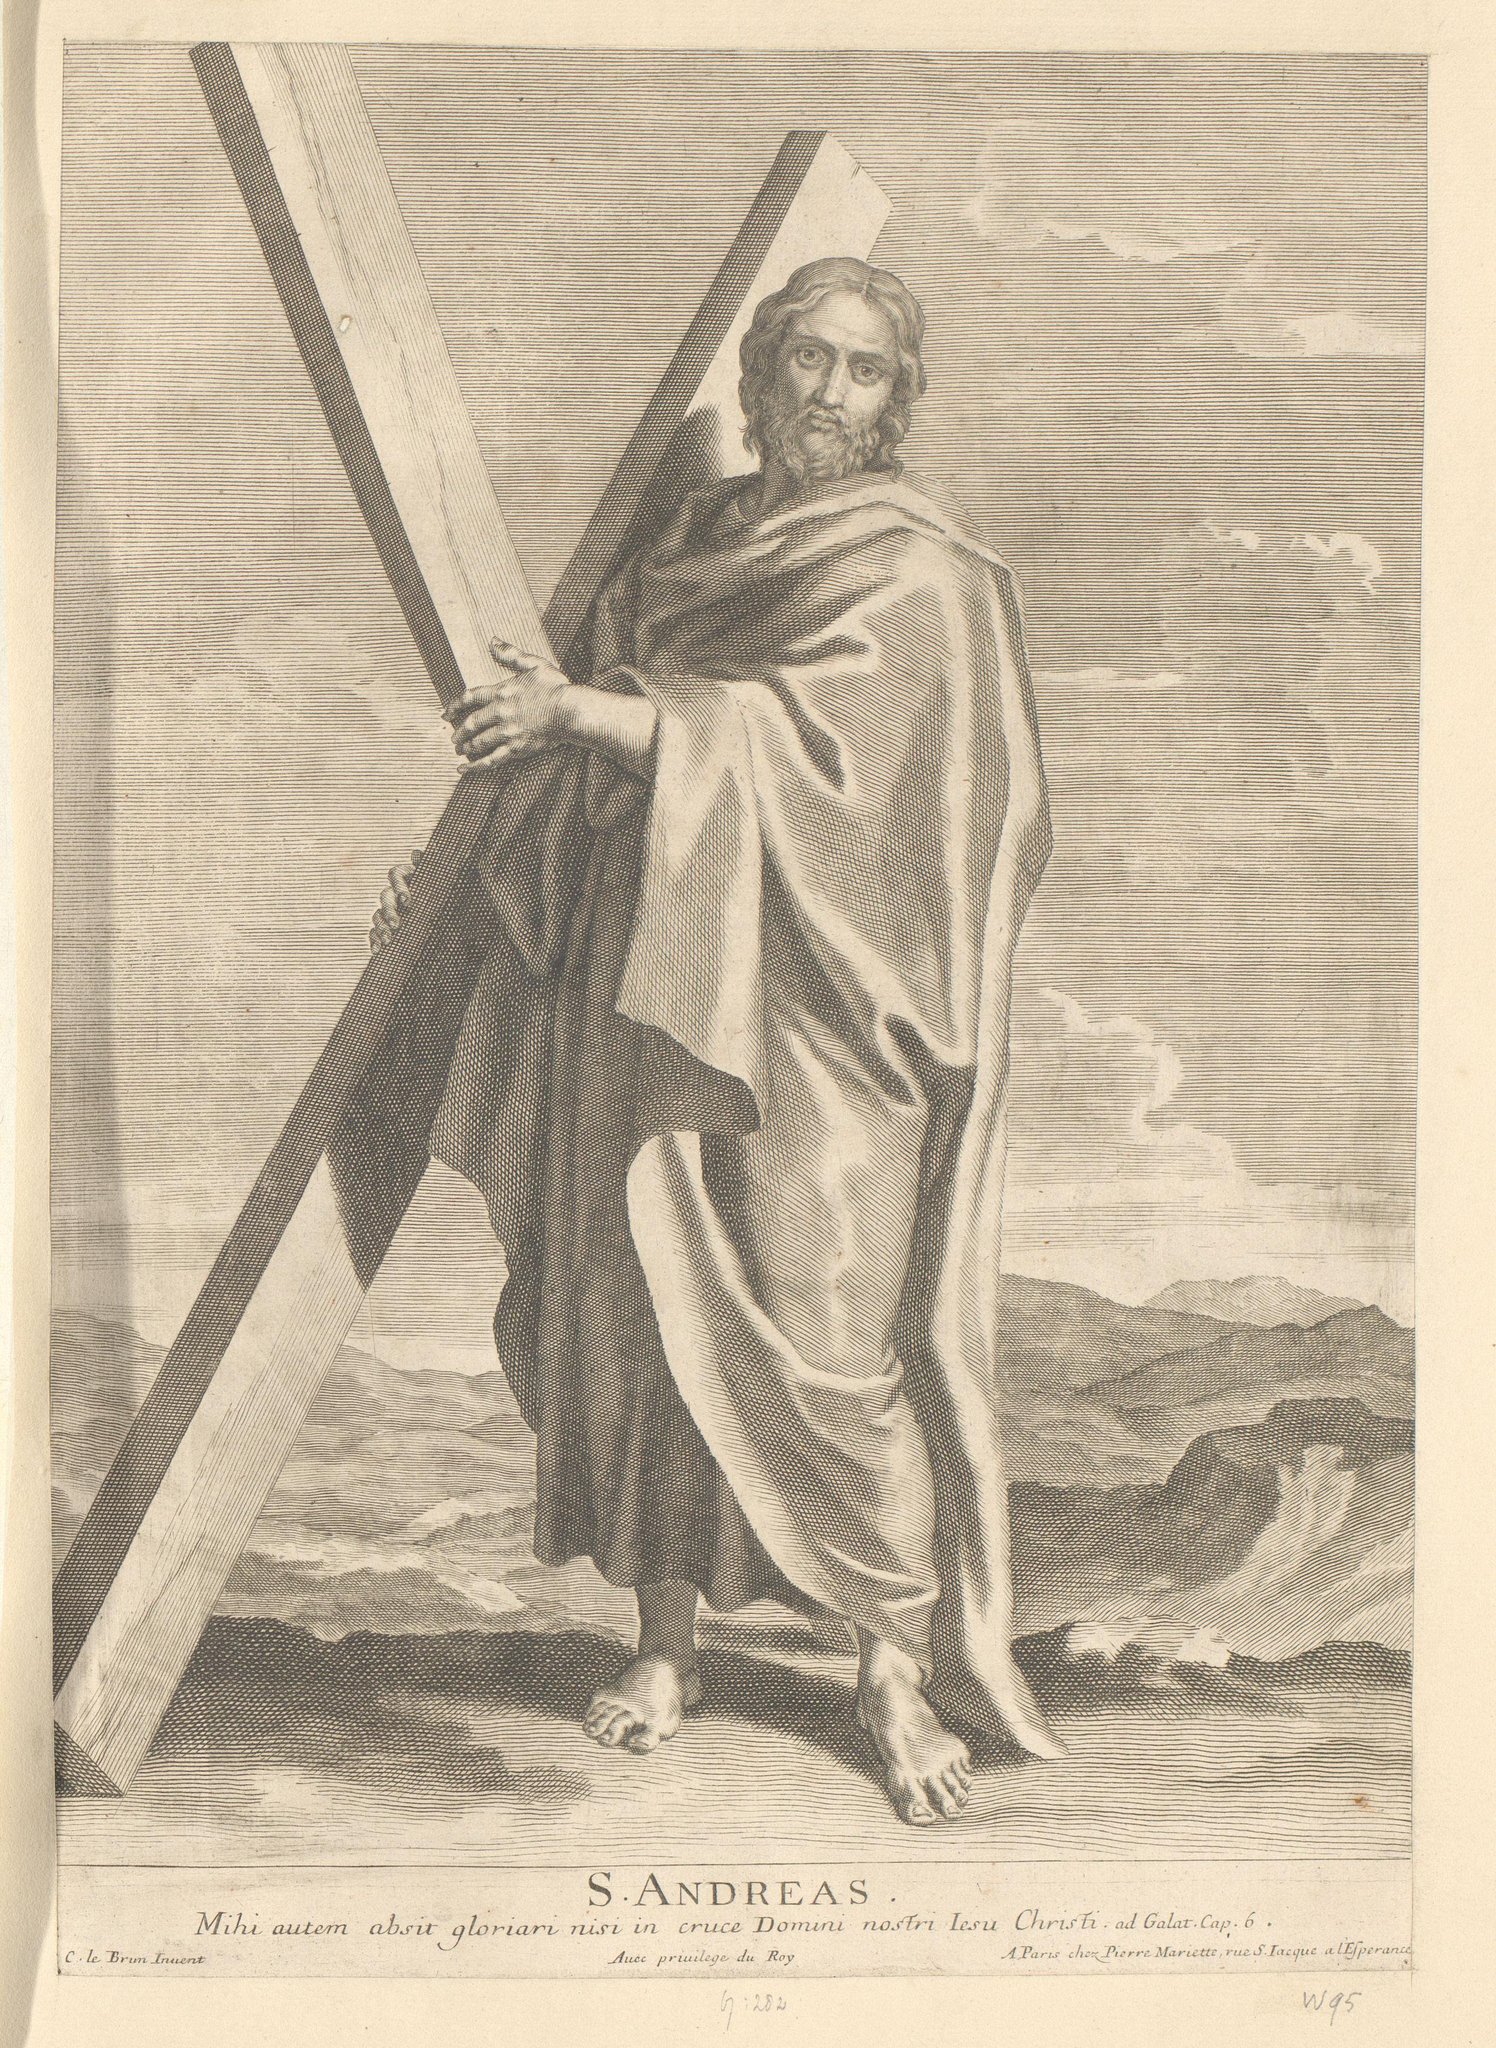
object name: album leaf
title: Apôtres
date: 1650-1700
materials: paper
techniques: engraving, etching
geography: paris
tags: the apostle andrew; possible attributes: book, x-shaped cross, fish, fishing-net, rope, scroll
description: Deze prent maakt deel uit van een album.